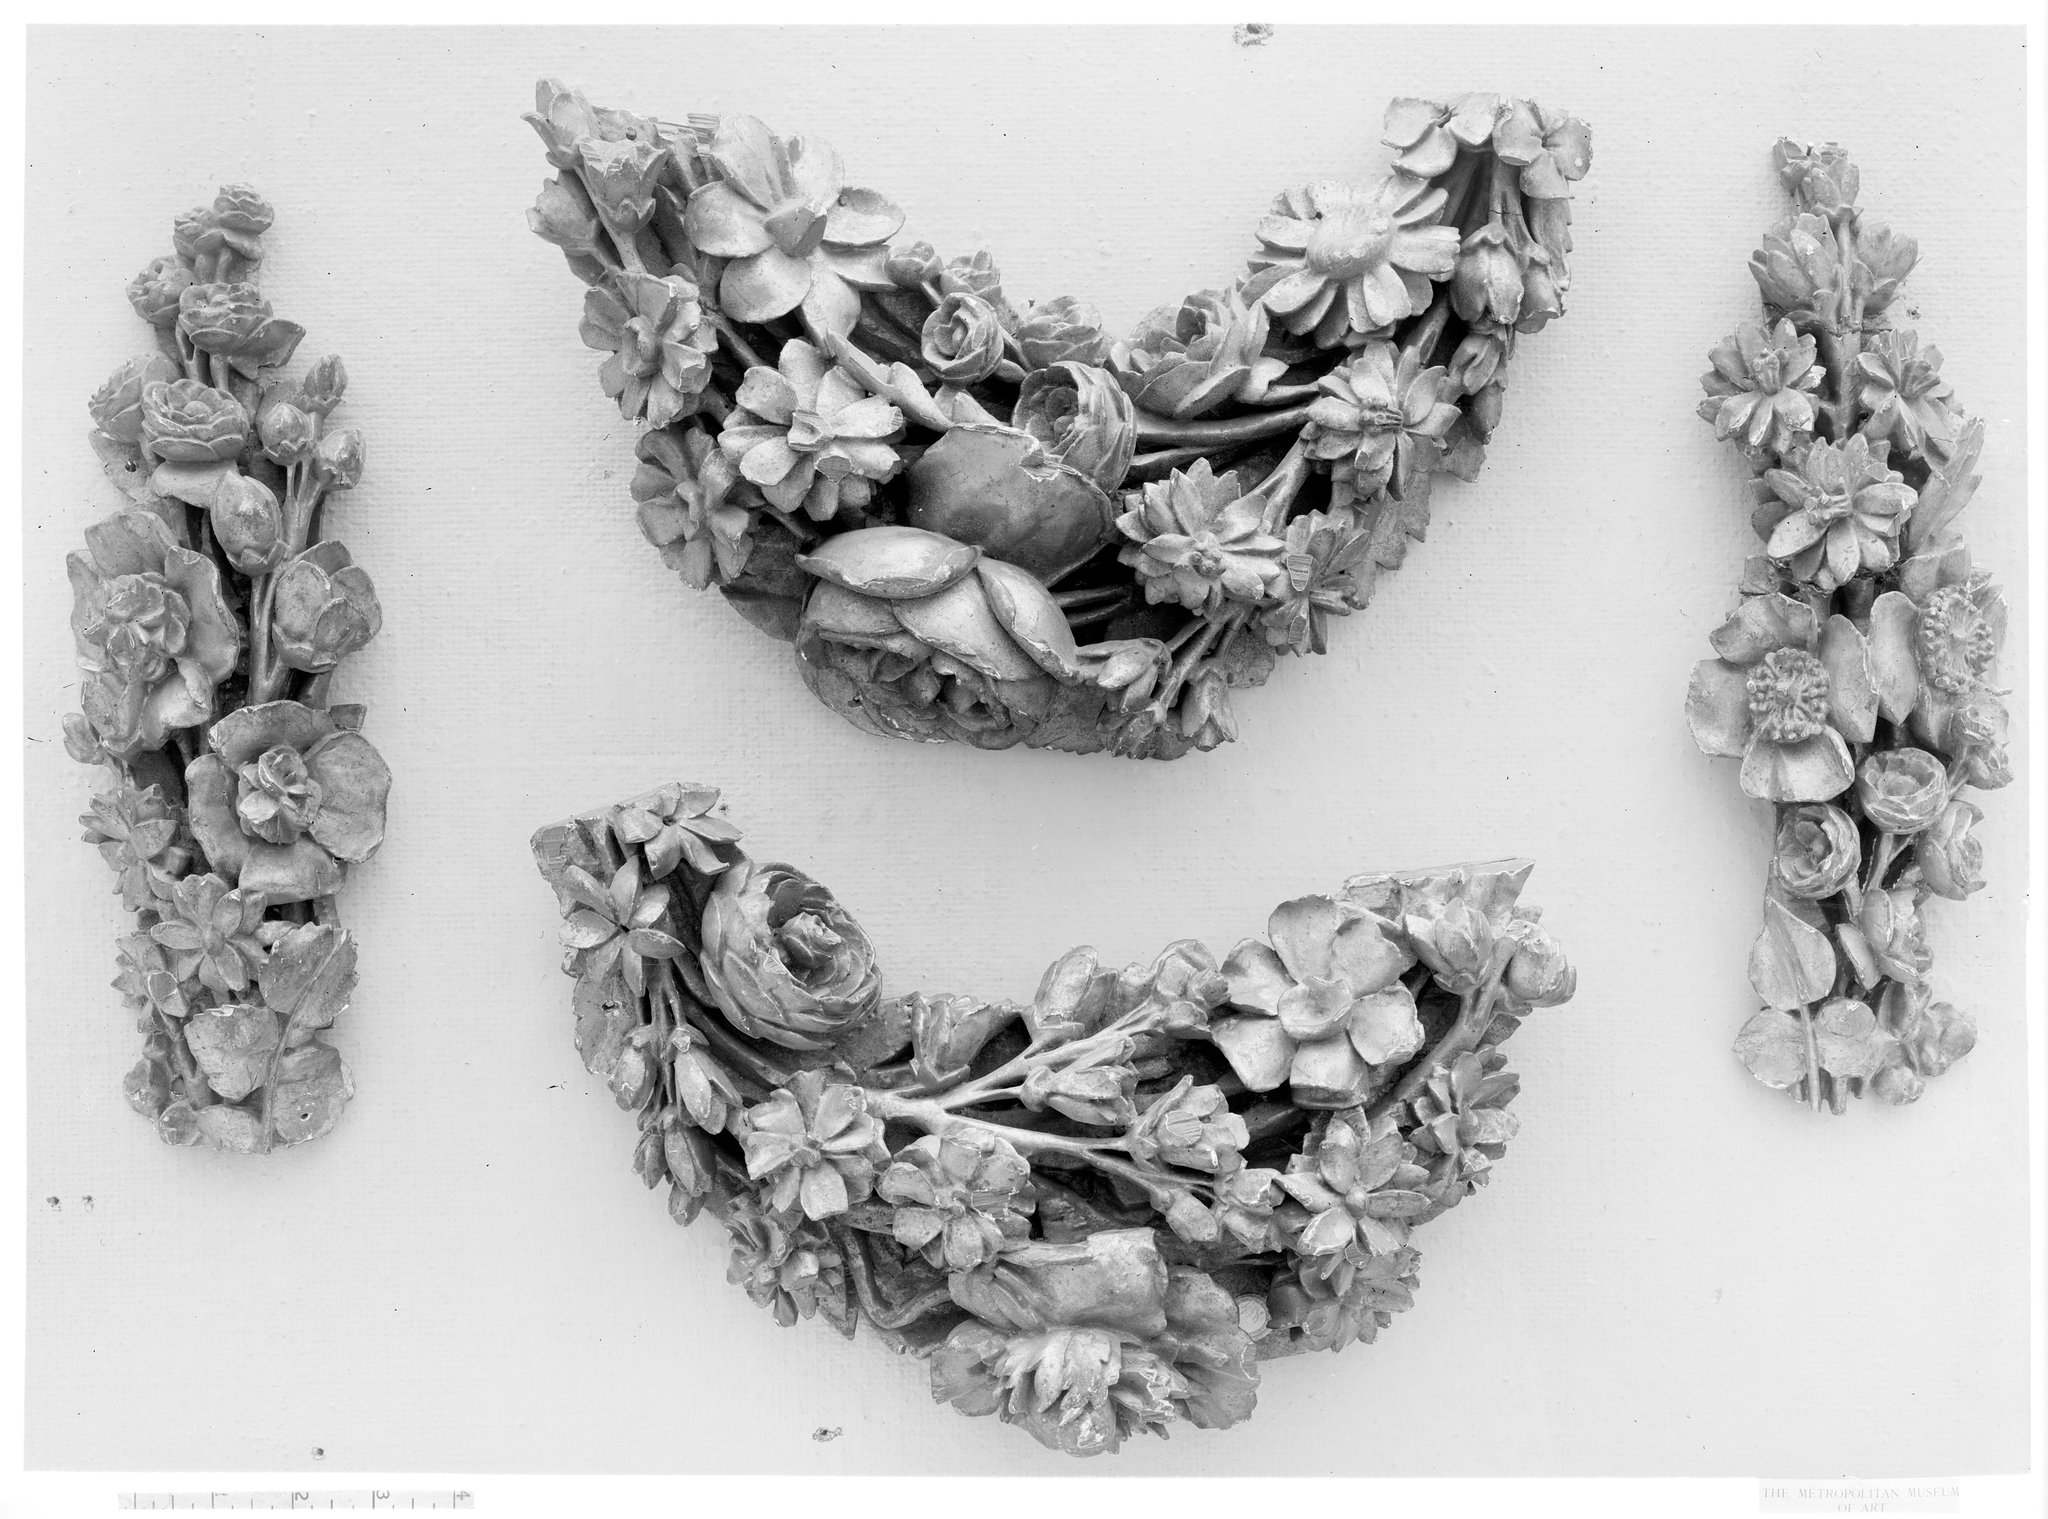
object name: garland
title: Garland (part of a set)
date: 1701-1800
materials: gilt, wood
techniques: carving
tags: garlands,flowers